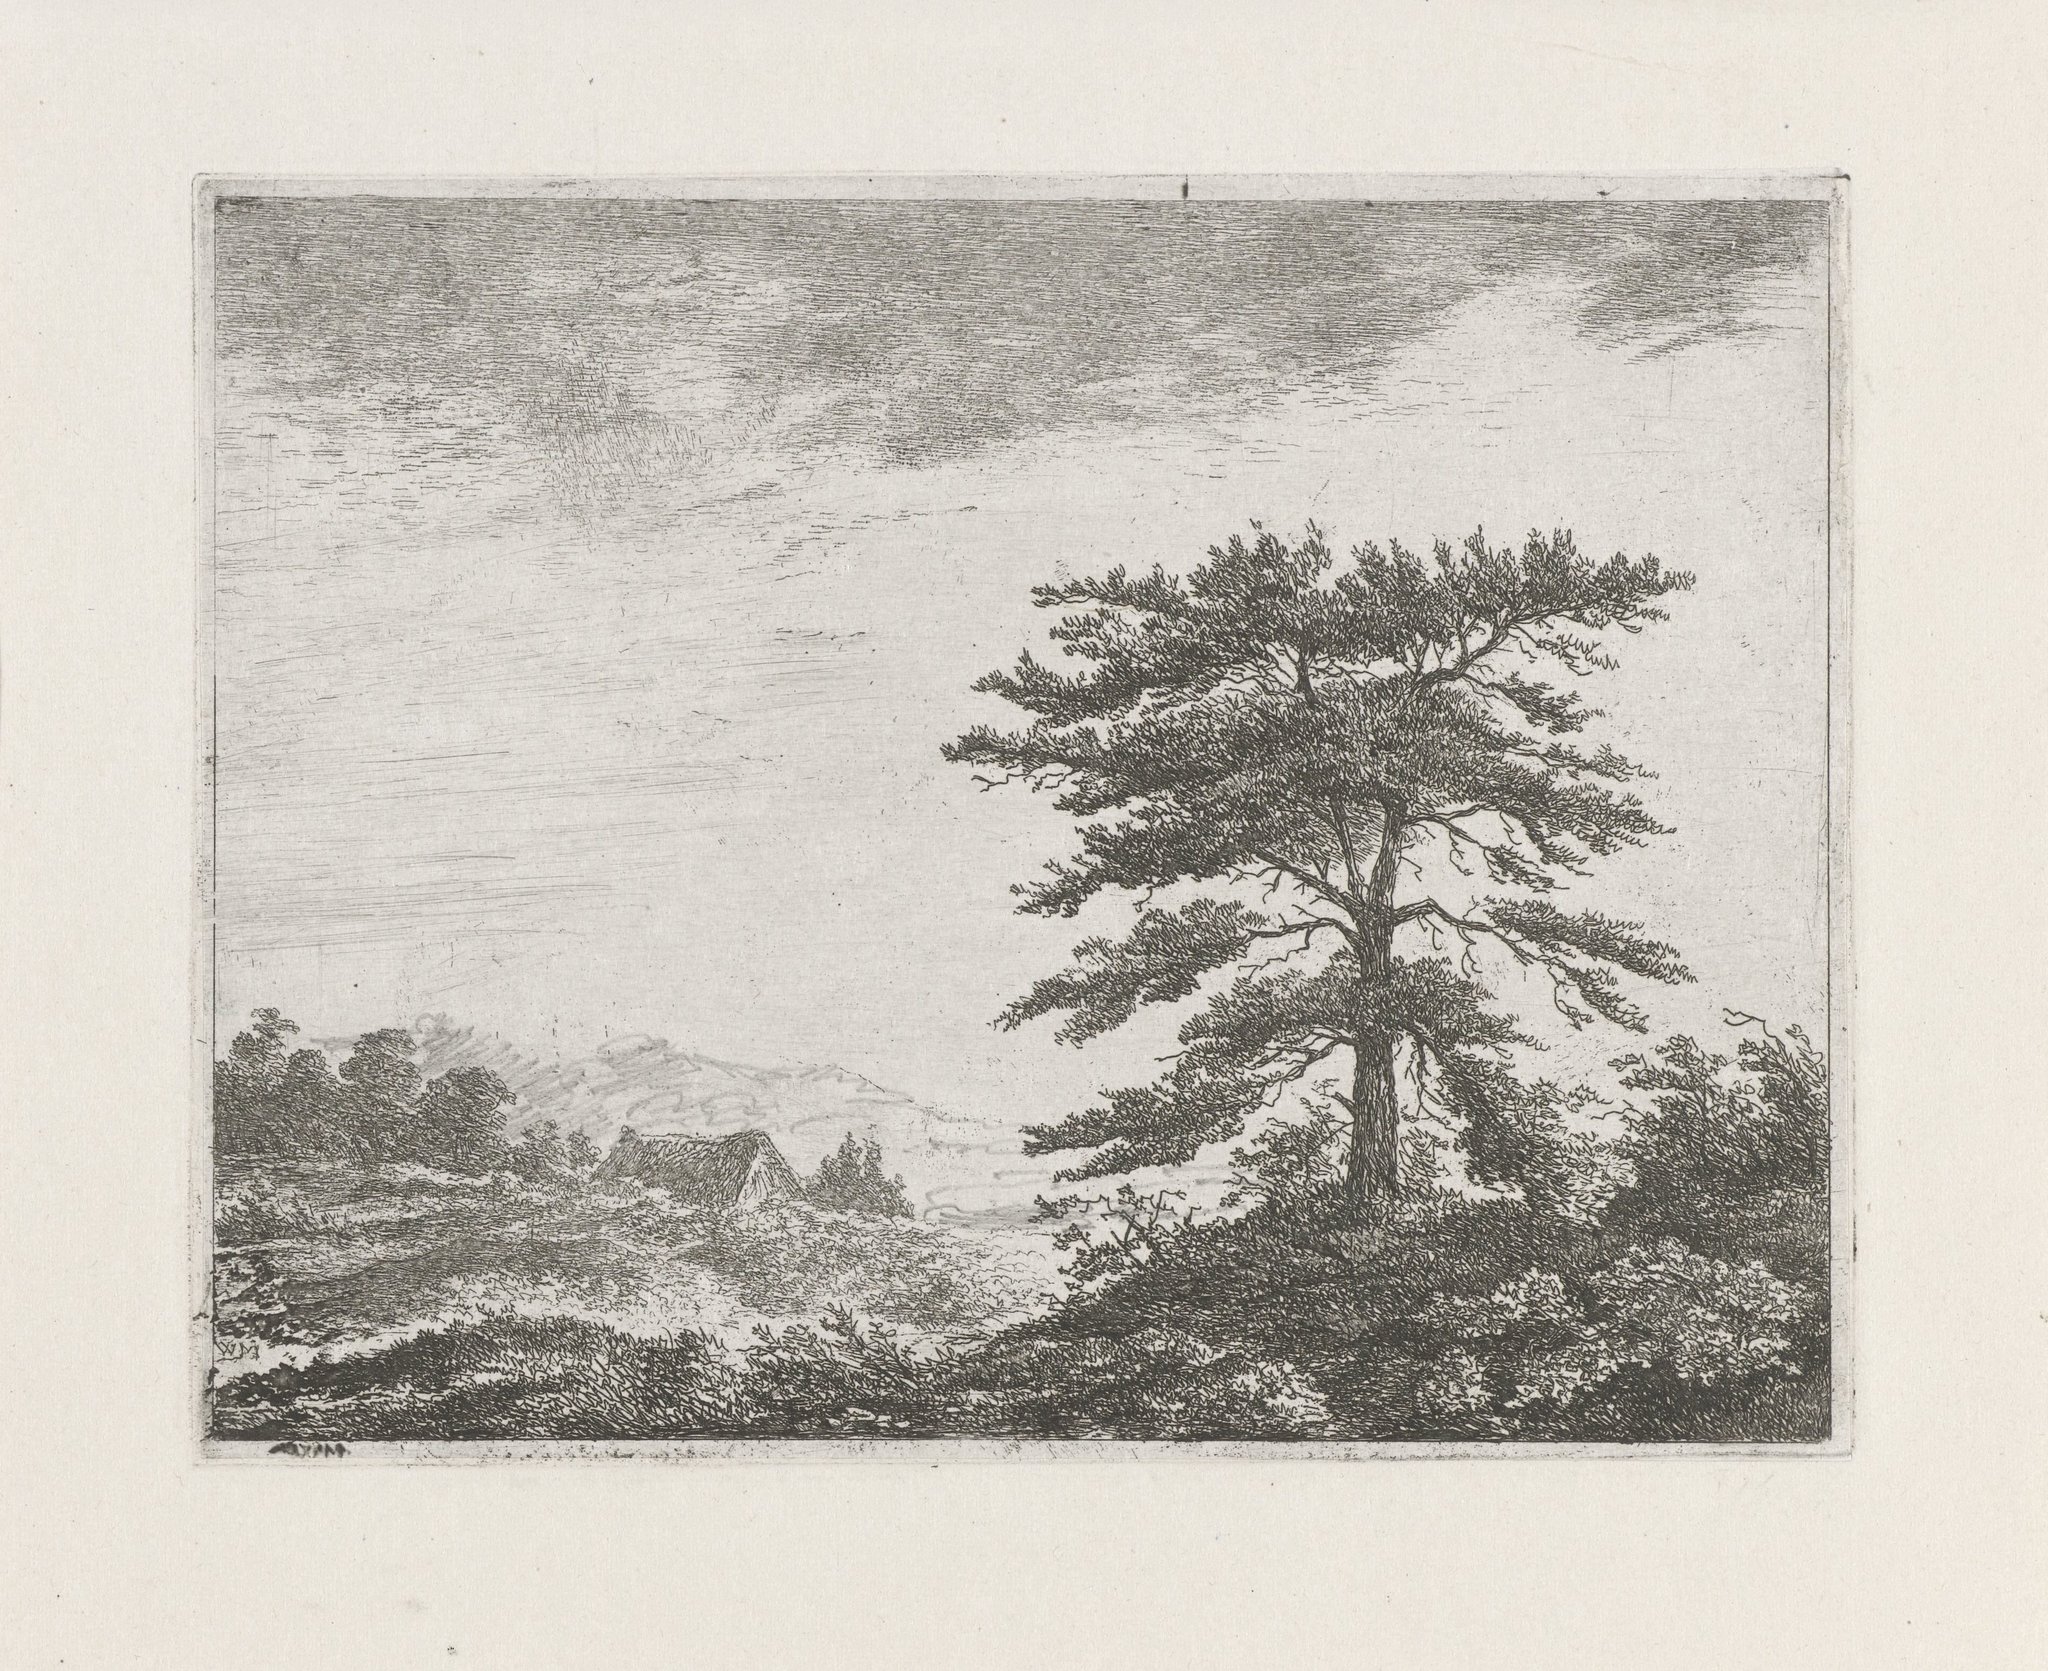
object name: print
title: Boom in een heidelandschap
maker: christiaan wilhelmus moorrees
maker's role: draughtsman, print maker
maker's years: 1801-1867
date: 1811-1867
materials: paper, pencil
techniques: etching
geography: netherlands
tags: trees, shrubs: broom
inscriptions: collector's mark: Lugt 2228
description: Een boom in een glooiend heidelandschap. Links het dak van een huis.